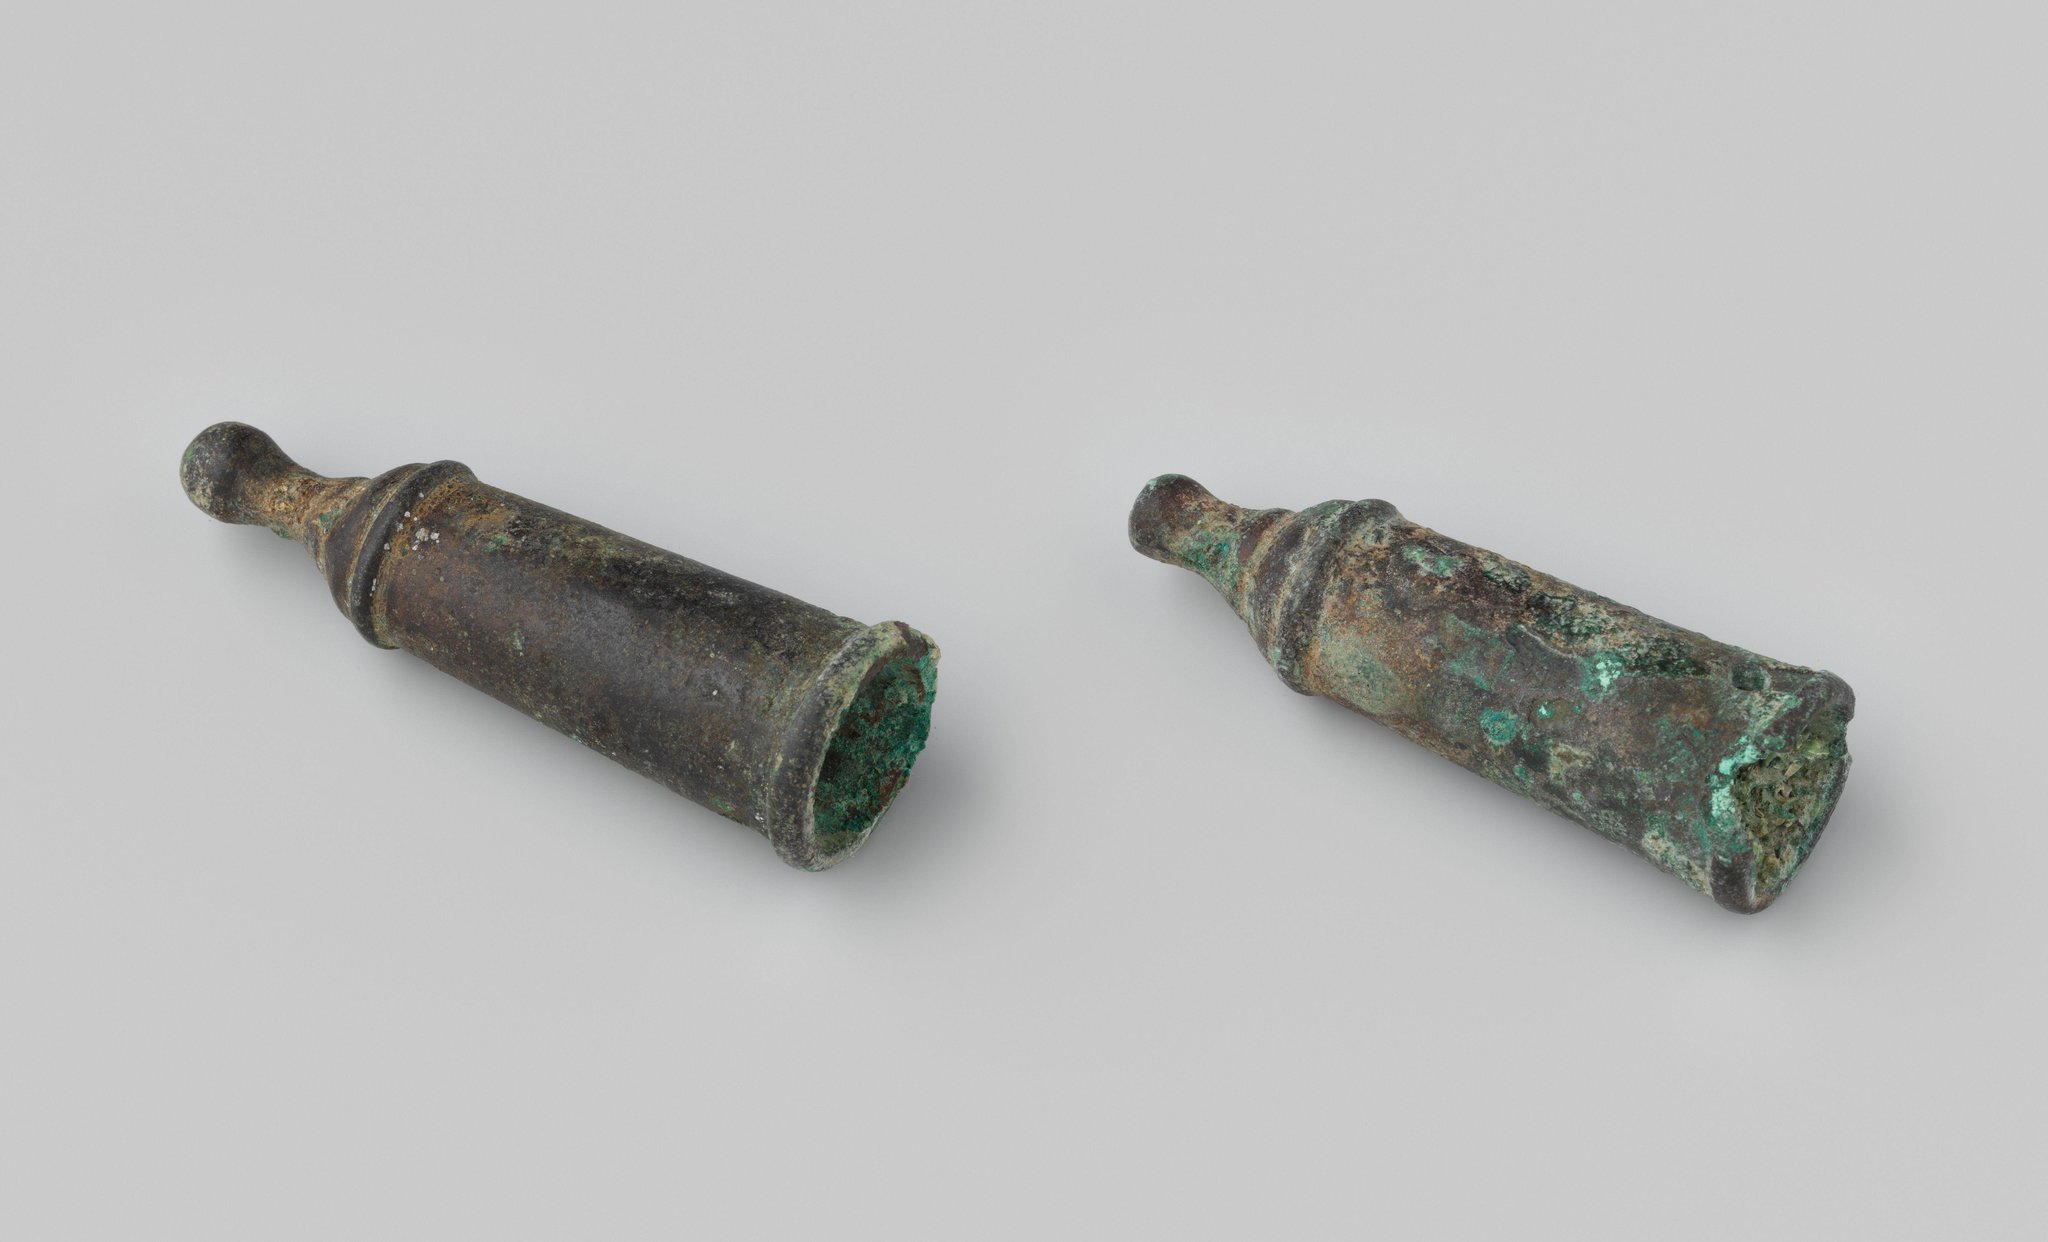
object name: clamp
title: Klemmen afkomstig uit het wrak van de Oost-Indiëvaarder Hollandia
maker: Anonymous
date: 1700-1743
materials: copper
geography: netherlands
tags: verenigde oostindische compagnie, hollandia (schip)